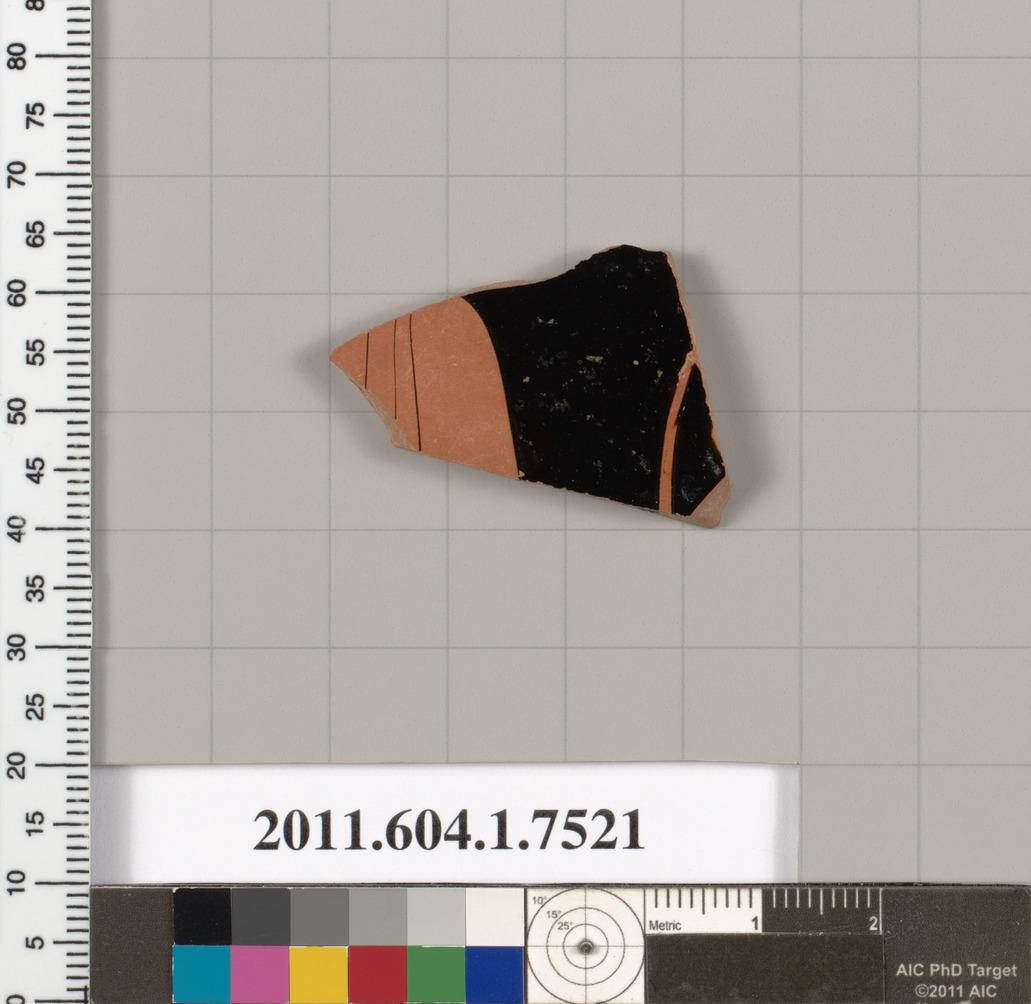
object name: kylix fragment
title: Terracotta fragment of a kylix (drinking cup)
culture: greek, attic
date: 460-450 BCE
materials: terracotta